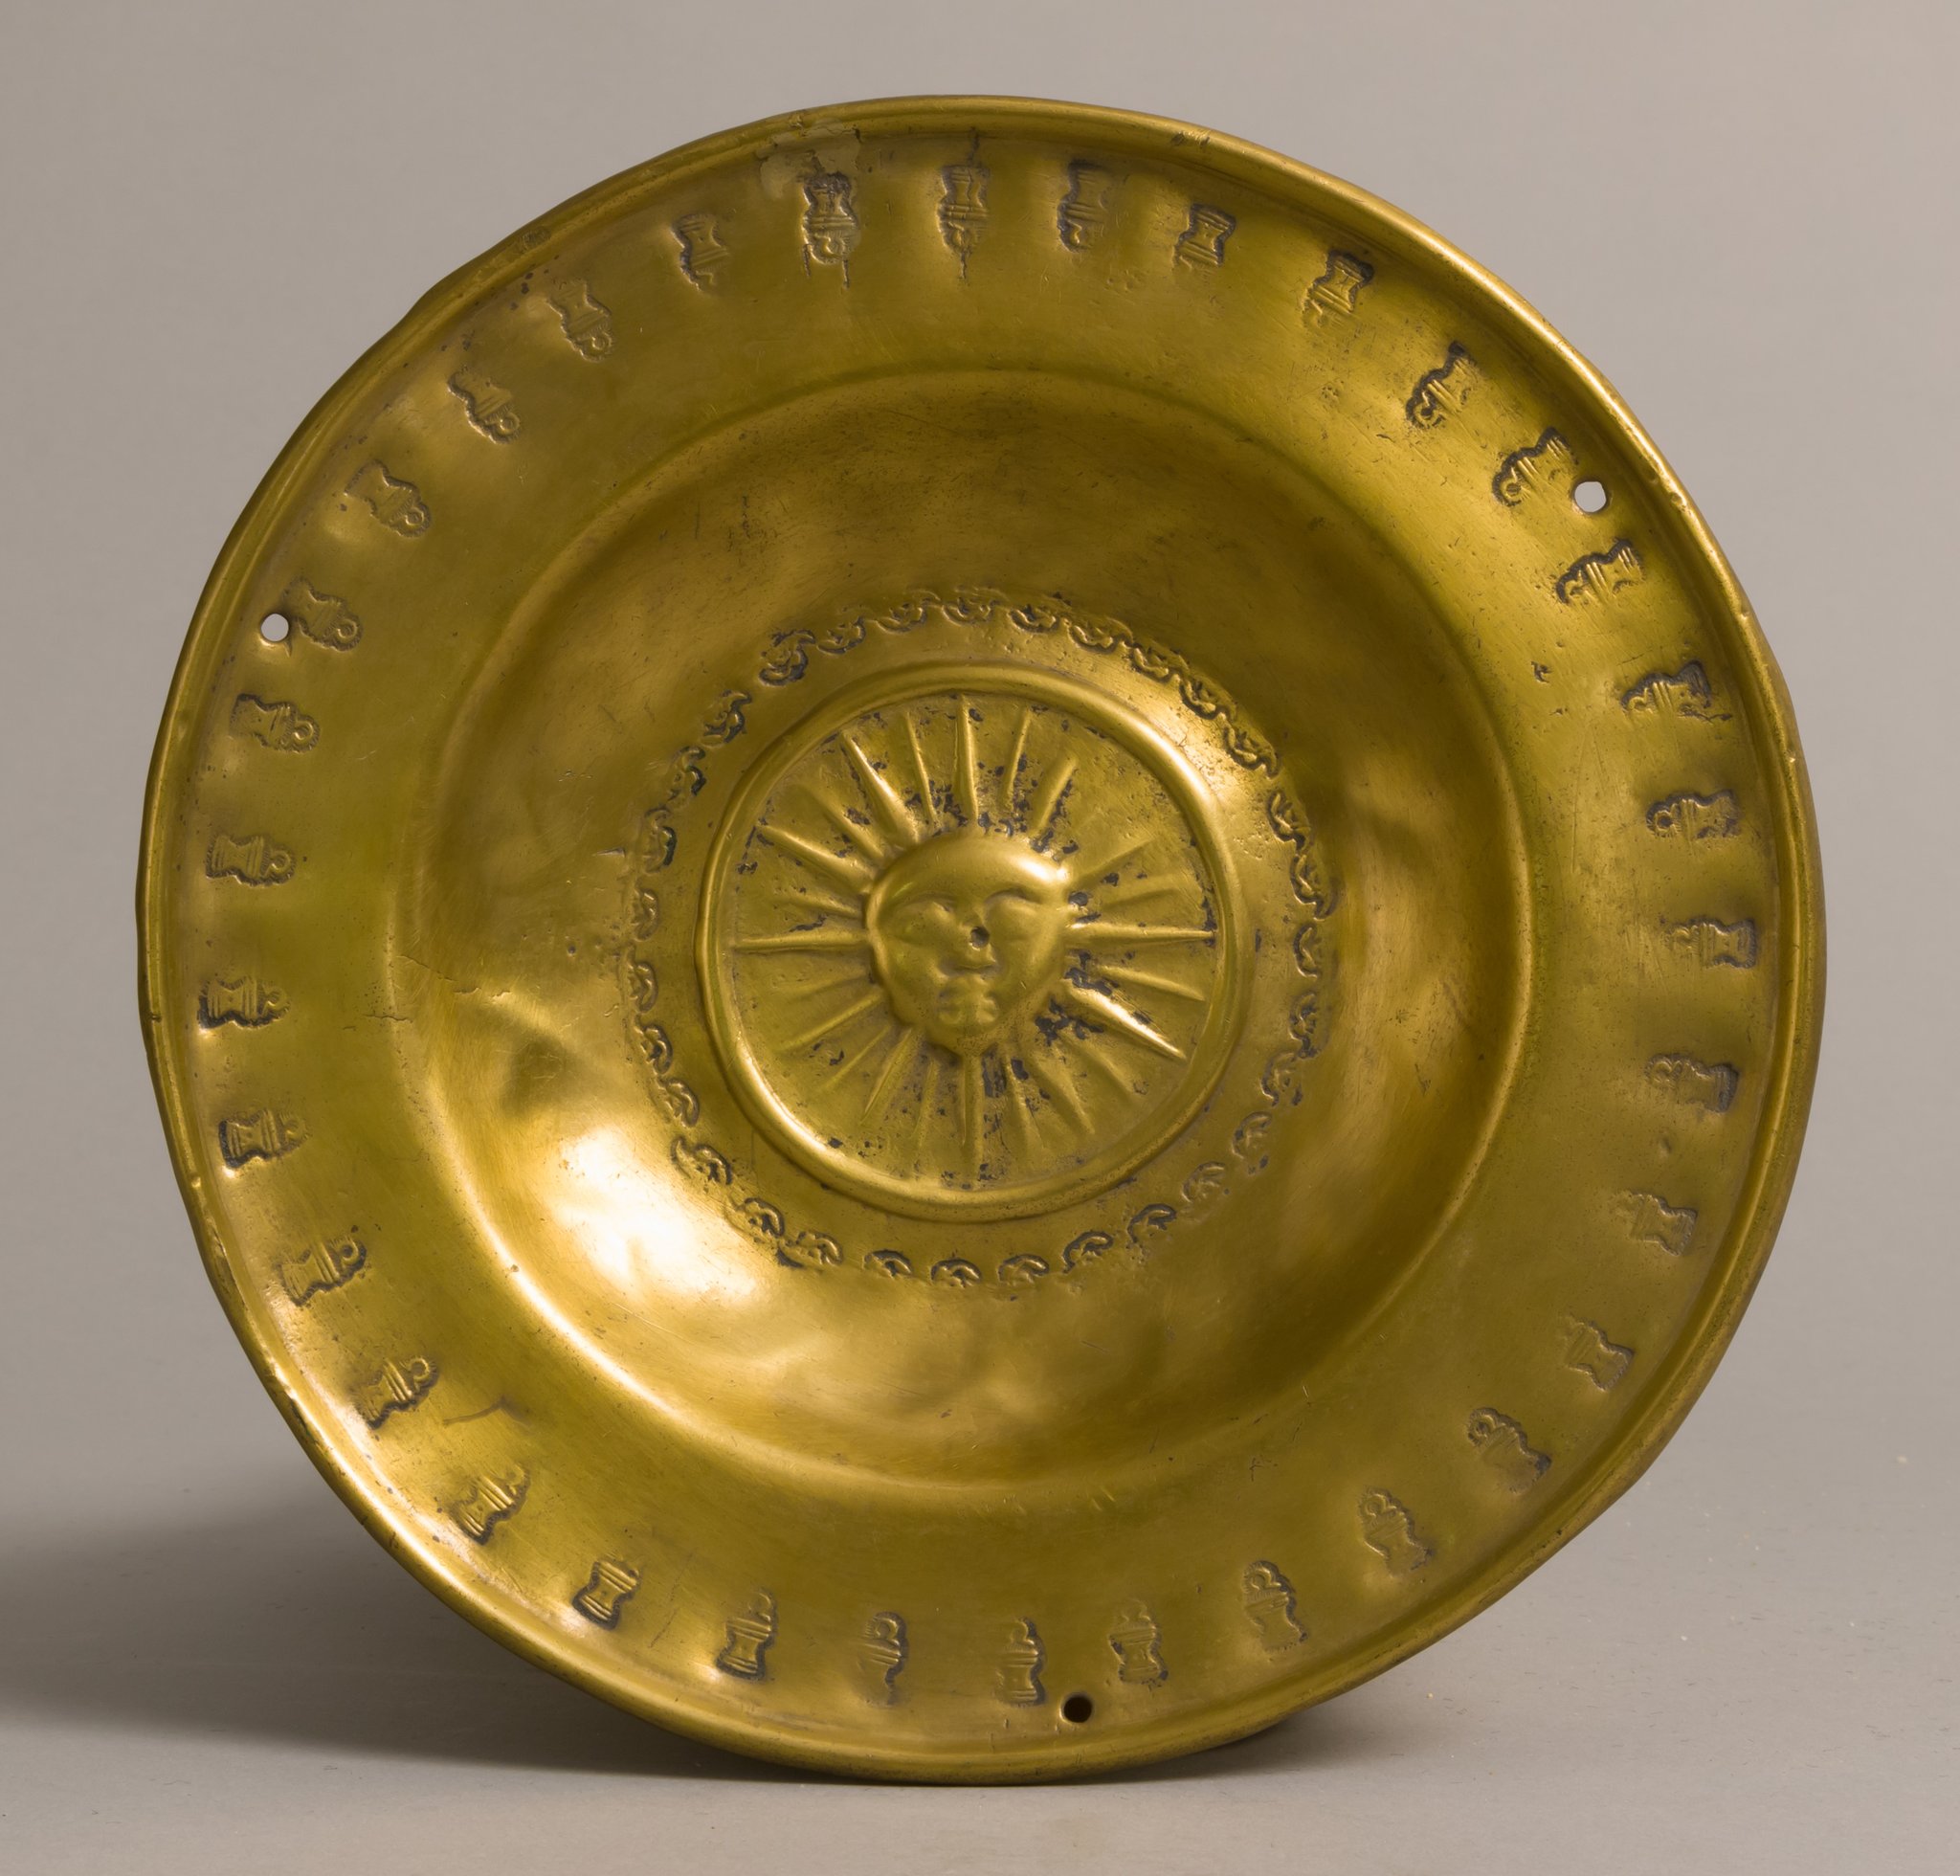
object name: dish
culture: german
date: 1501-1533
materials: brass